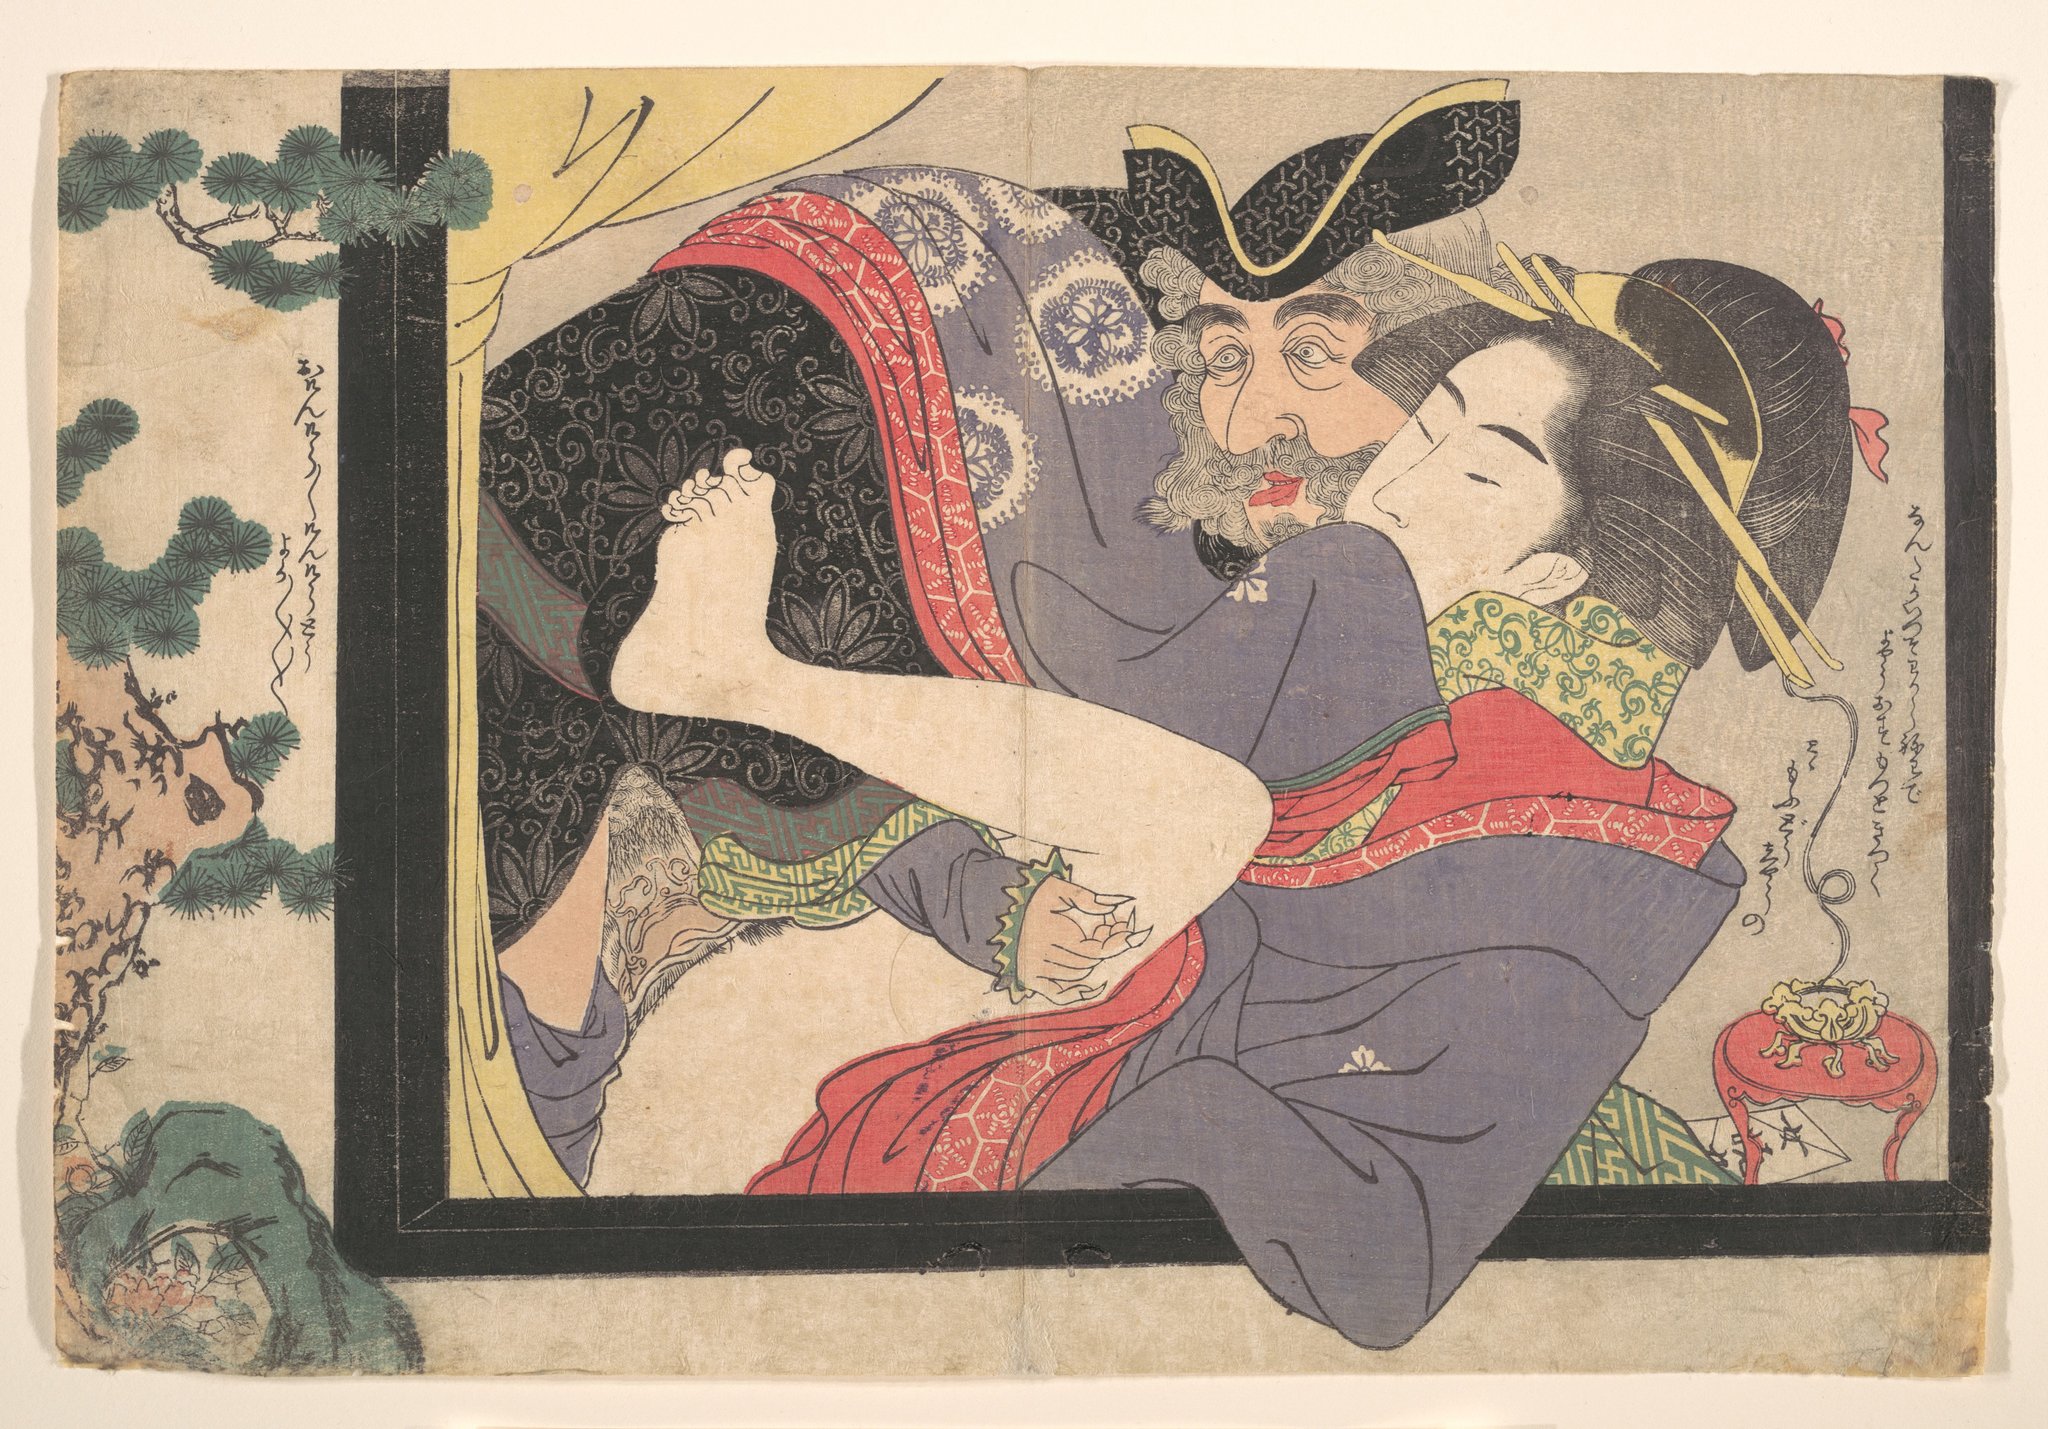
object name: print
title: Dutchman and Maruyama Courtesan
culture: japanese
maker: chōkyōsai eiri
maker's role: artist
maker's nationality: japanese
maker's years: 1789-1801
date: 1701-1800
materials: ink, paper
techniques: woodblock print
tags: men,women